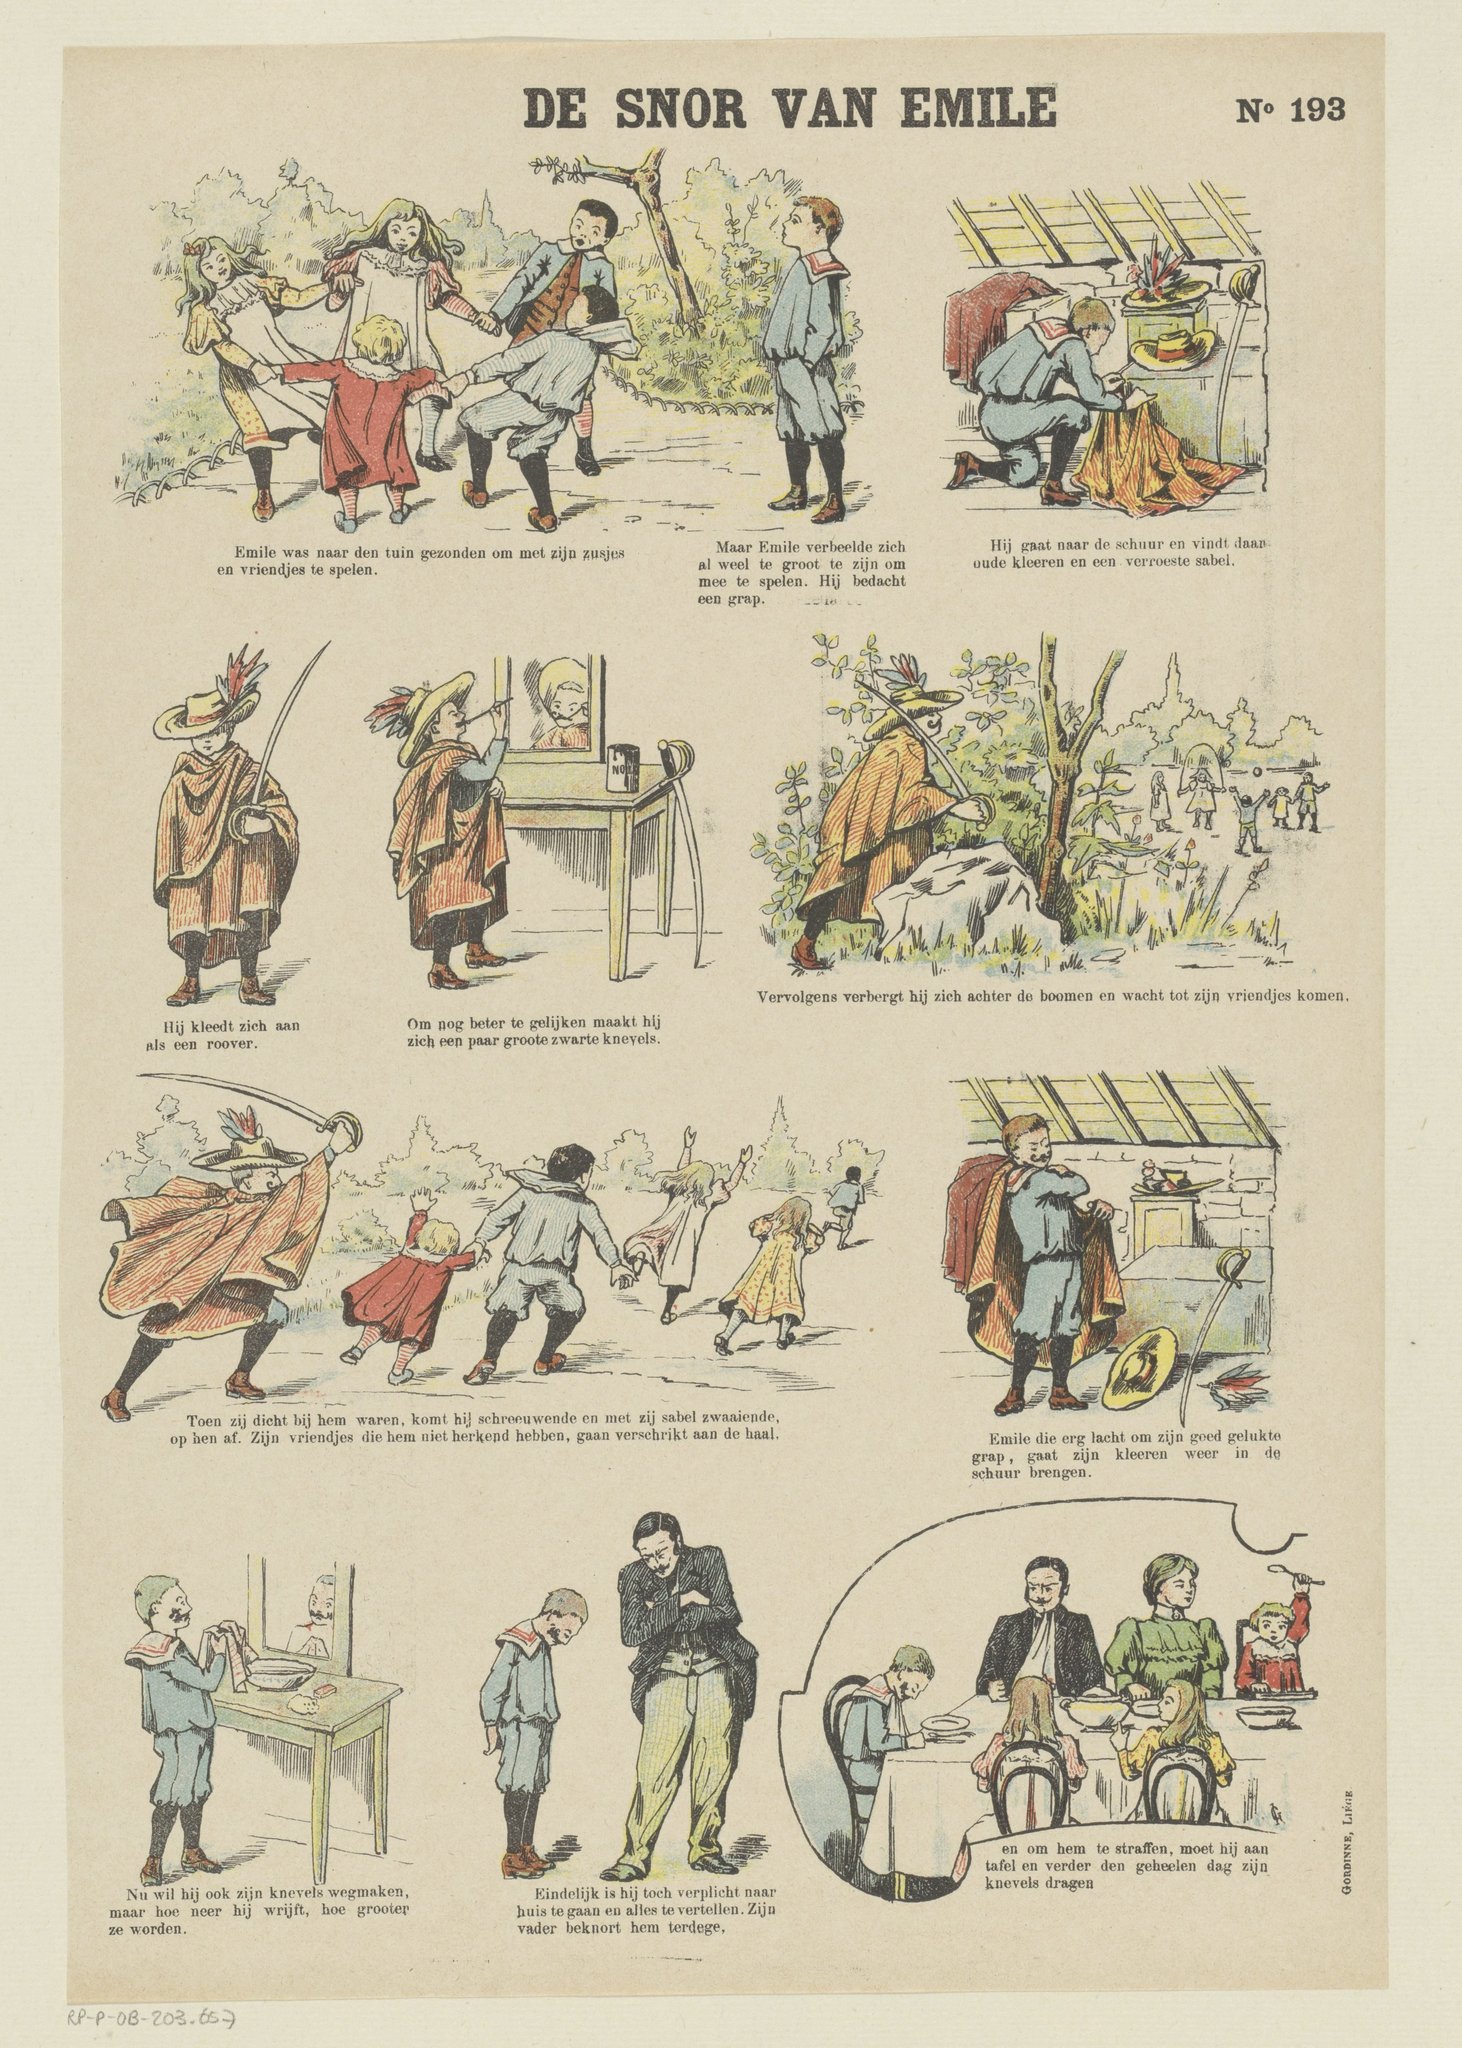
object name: print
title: De snor van Emile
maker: monogrammist jgr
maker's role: print maker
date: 1894-1959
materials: paper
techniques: lithograph, letterpress printing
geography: liège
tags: correction of naughty children, children's games and plays, bad behaviour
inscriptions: collector's mark: Lugt 2760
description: Blad met 10 voorstellingen over de jongen Emile die zich verkleedt als rover en zijn vrienden laat schrikken. Onder elke afbeelding een onderschrift. Genummerd rechtsboven: No 193.